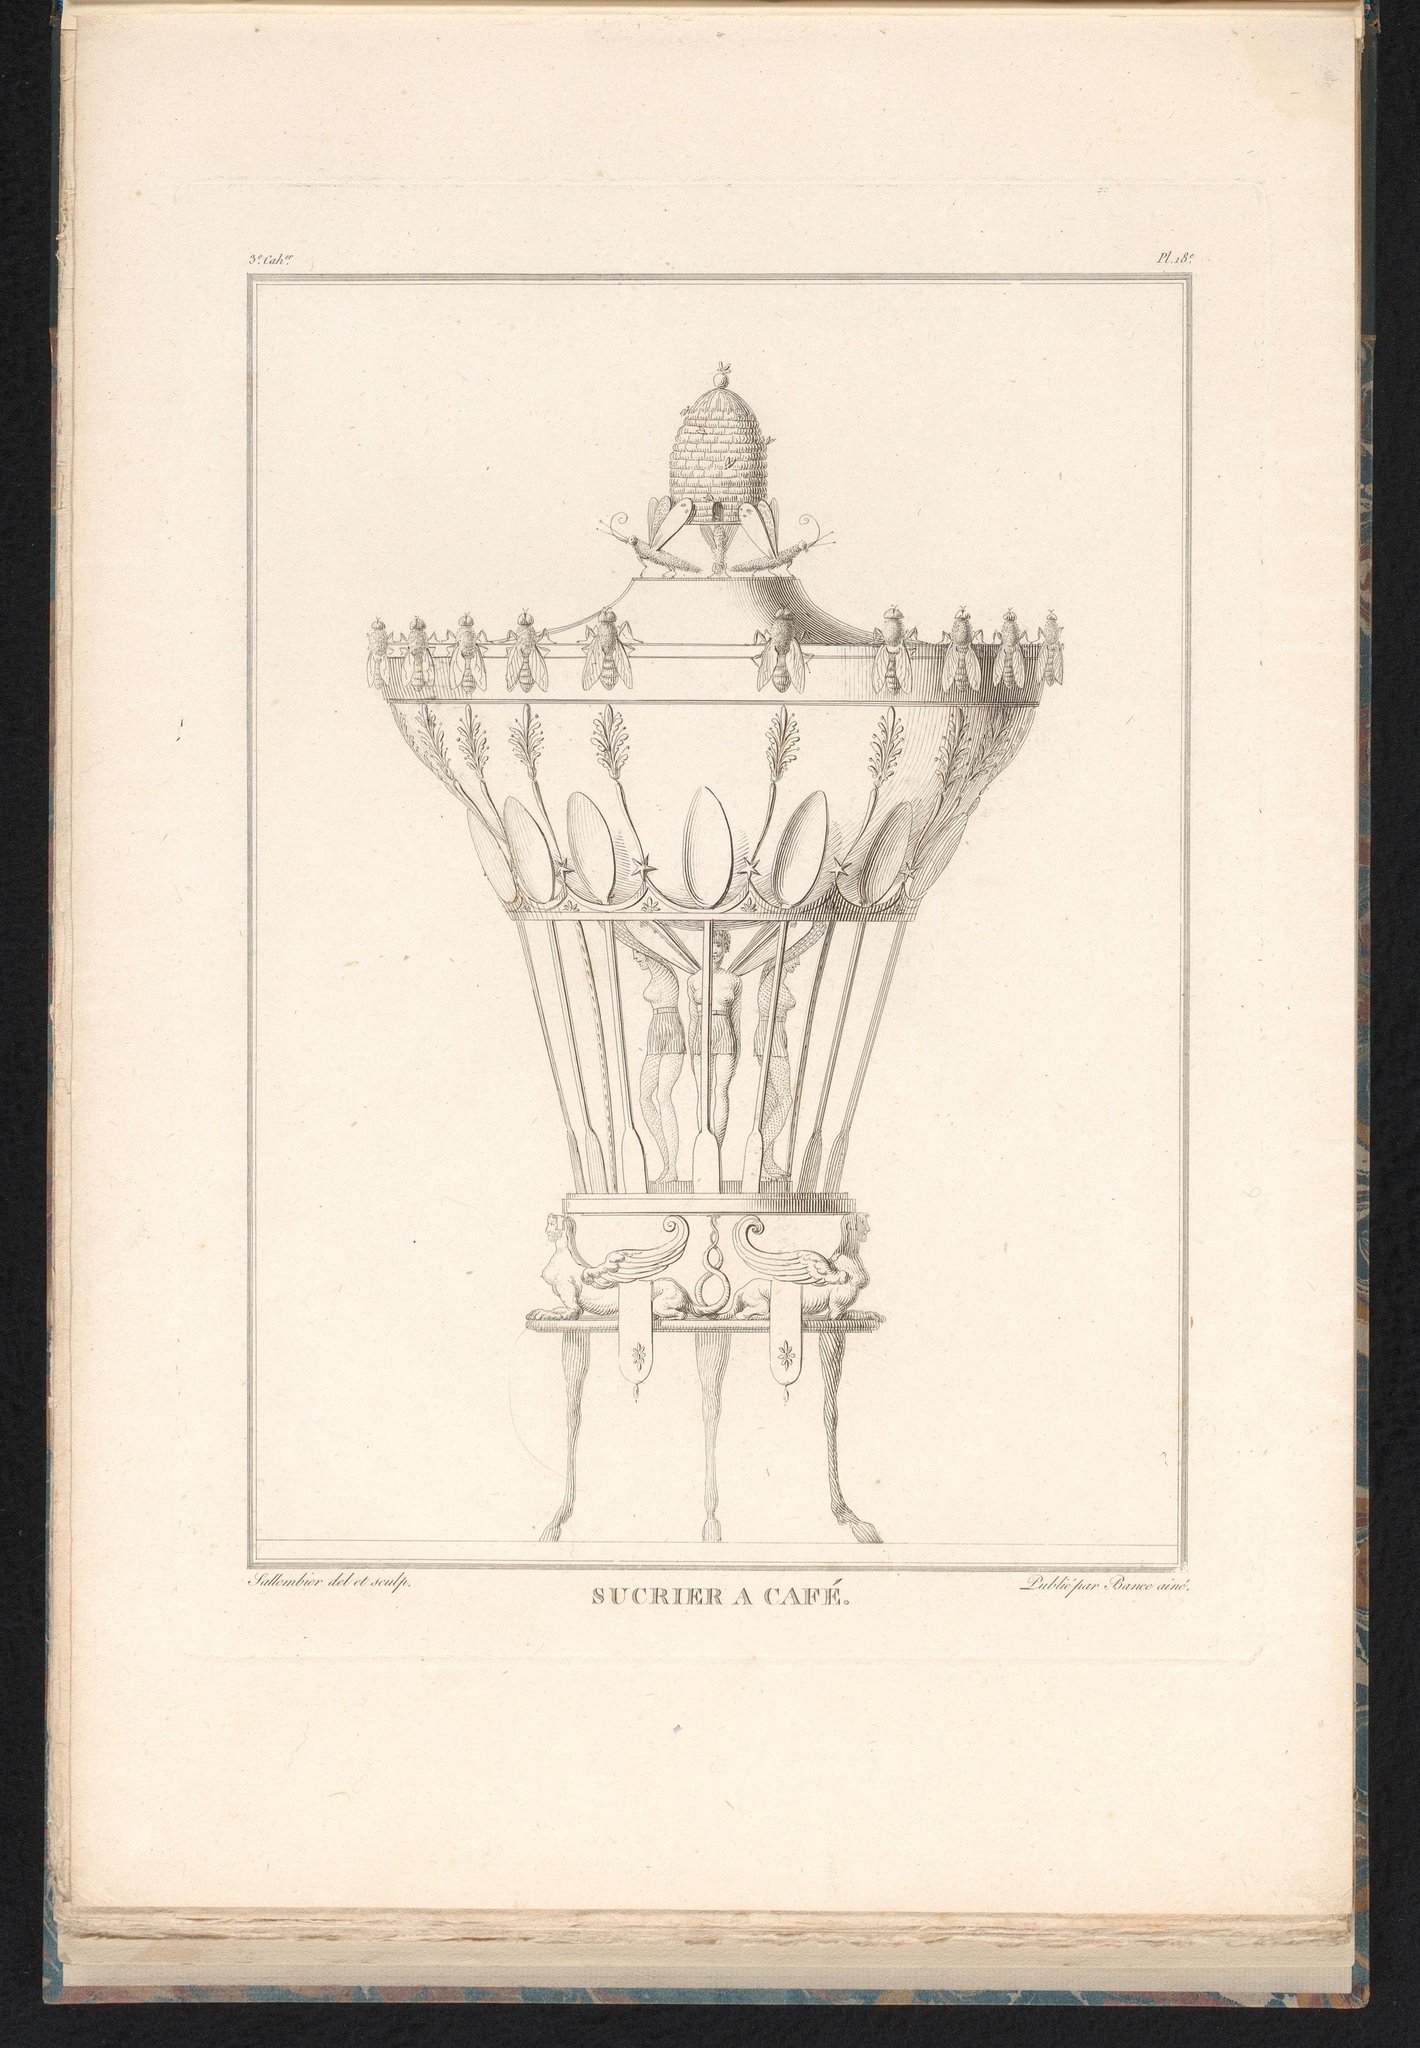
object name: ornament print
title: Suikerpot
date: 1805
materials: paper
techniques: etching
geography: paris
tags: sugar-basin, insects: bee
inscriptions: number: ‘3.e Cah.er’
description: Ontwerp voor een suikerpot gedecoreerd met bijen, gedragen door figuren met vleugels. Prent maakt deel uit van een album.